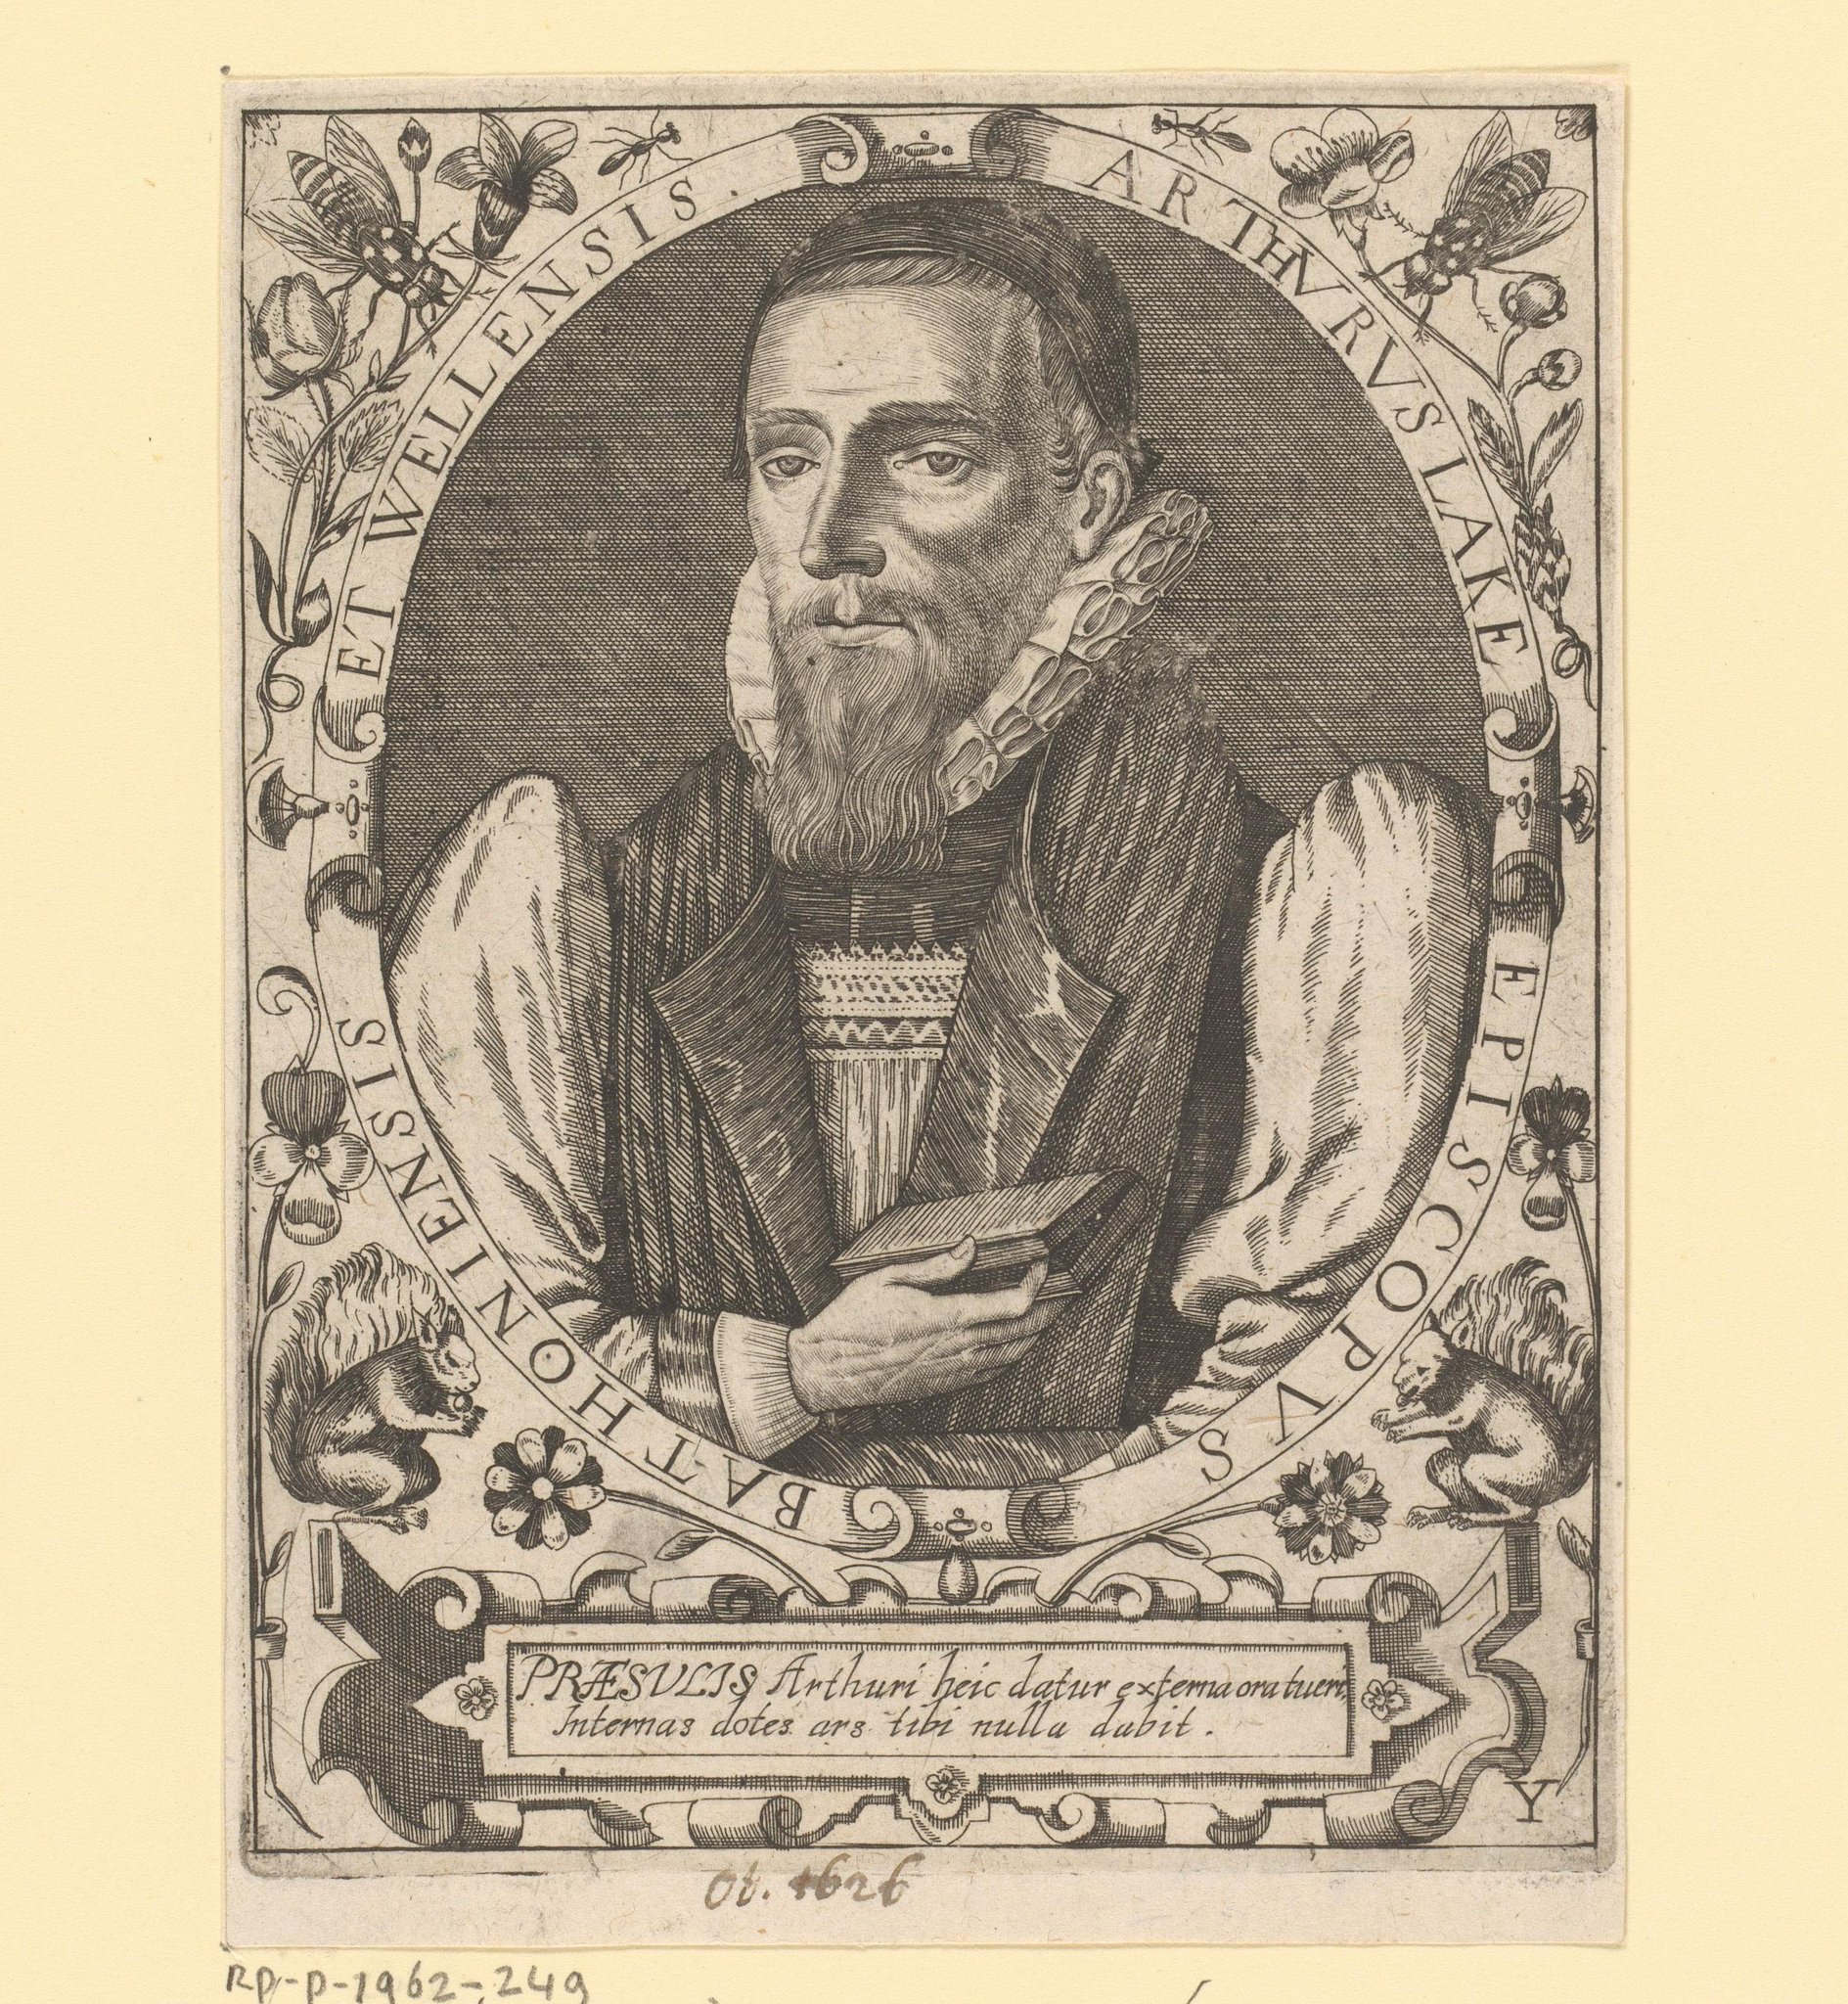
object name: print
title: Portret van Arthur Lake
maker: paul de zetter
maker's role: print maker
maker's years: 1600-1667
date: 1650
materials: paper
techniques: engraving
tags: theologian, historical persons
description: Prent gebruikt in: Boissard, Jean Jacques. Bibliotheca chalcographica. 8 dln. Frankfurt am Main: Johannes Ammon, 1650-1652. Ook gebruikt in latere edities. Eerdere staat van prent waarschijnlijk verschenen in: Boissard, Jean-Jacques, Bibliotheca sive thesaurus virtutis et gloriae: in quo continentus illustrium eruditione & doctrina virorum effigies & vitae (...). 5 dln. Frankfurt am main: Guilielmi Fitzeri en erven Theodor de Bry, 1628-1632. Mogelijk ook in latere edities.